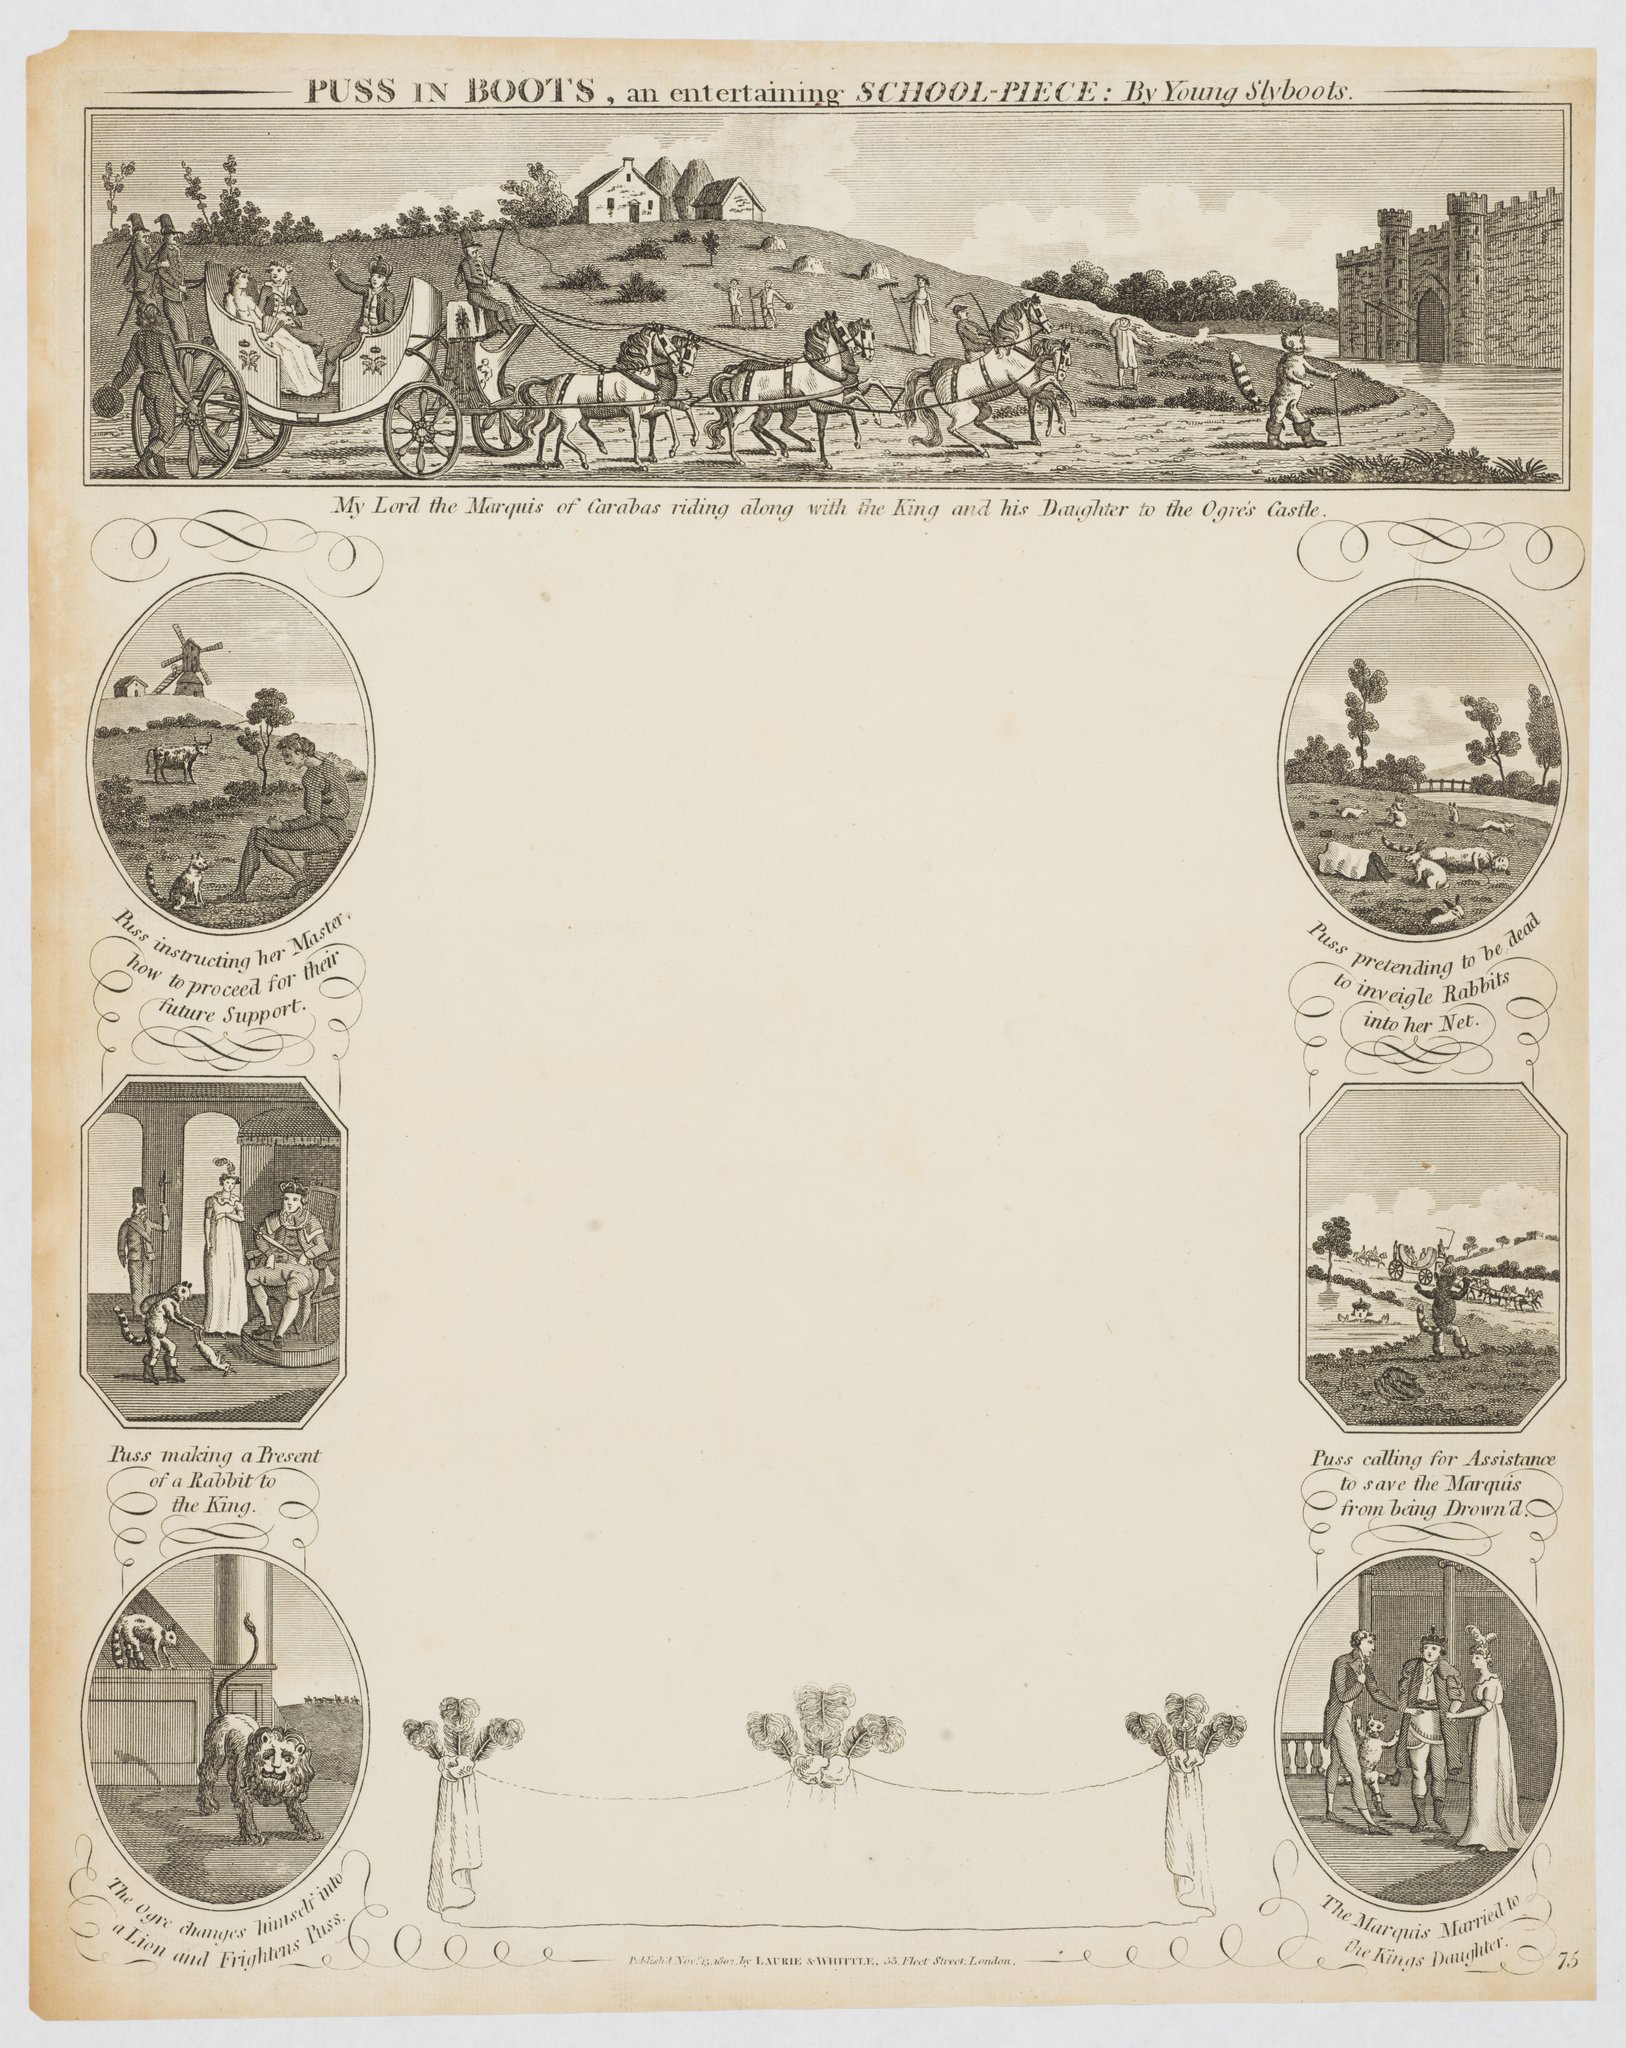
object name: print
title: Puss in Boots, an entertaining School-Piece: by Young Slyboots [School piece or Penmanship sheet]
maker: laurie & whittle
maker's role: publisher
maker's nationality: british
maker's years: 1794-1836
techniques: engraving, etching